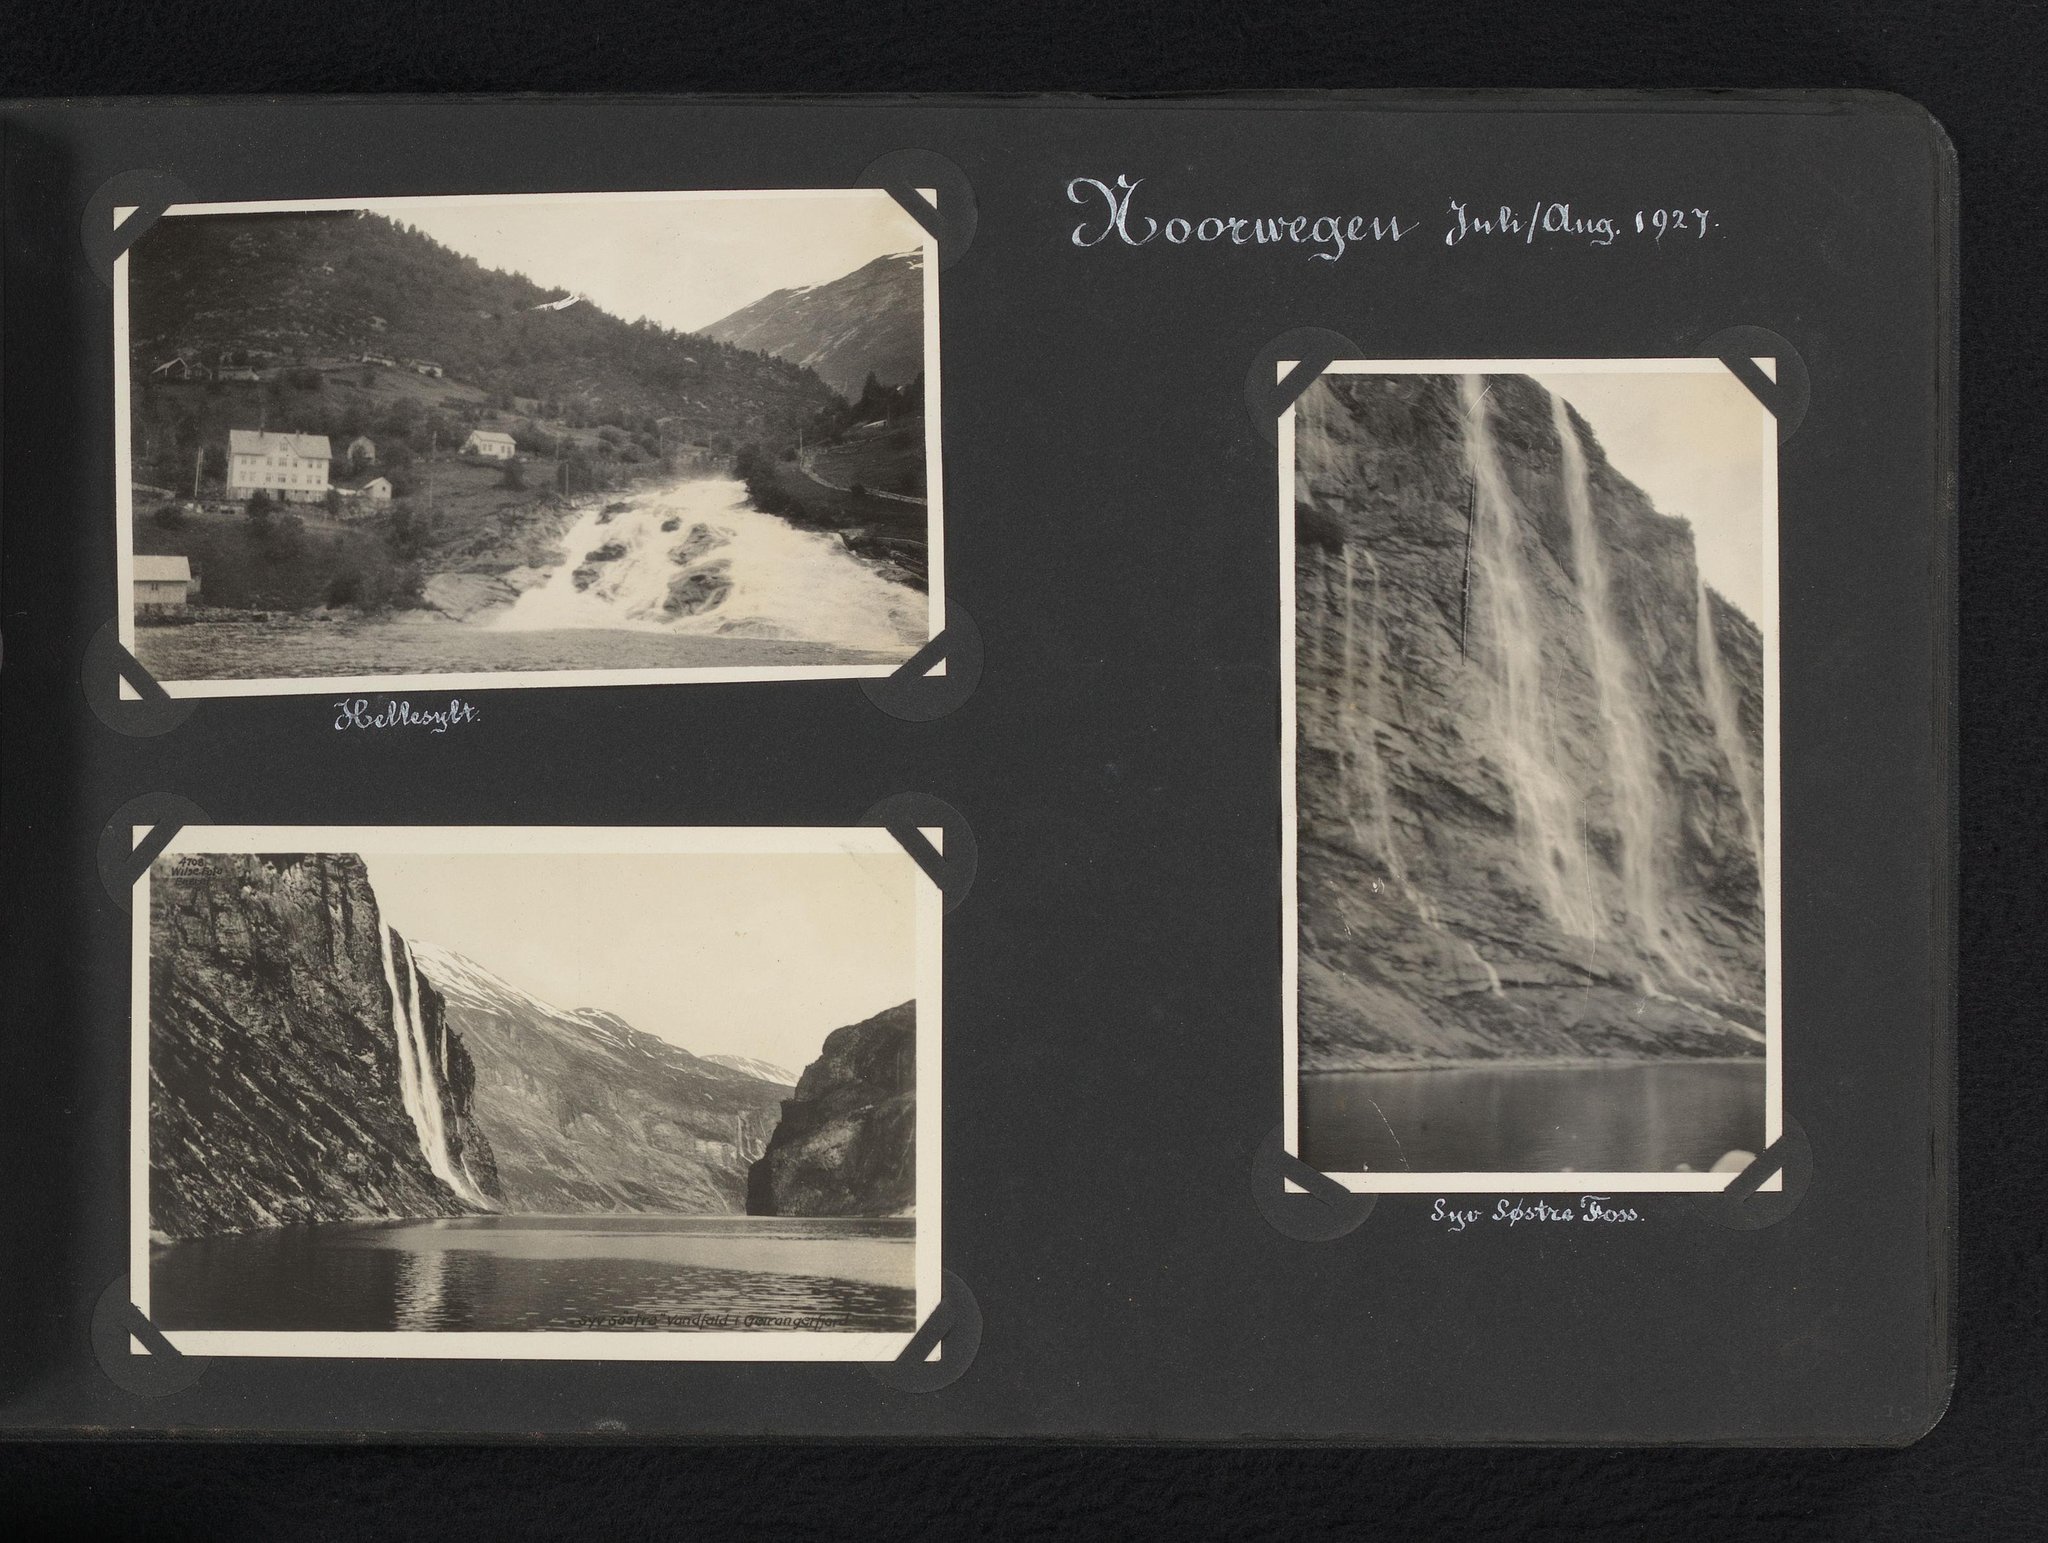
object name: ansichtkaart, prentbriefkaart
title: Drie foto's, waarvan één prentbriefkaart, van Hellesylt en de Waterval van de Zeven Zusters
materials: paper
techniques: gelatin silver print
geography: norway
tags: waterfall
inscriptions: inscription: ‘Syv Sostre Foss’, inscription: ‘Hellesylt’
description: Deze foto's maken deel uit van een album.